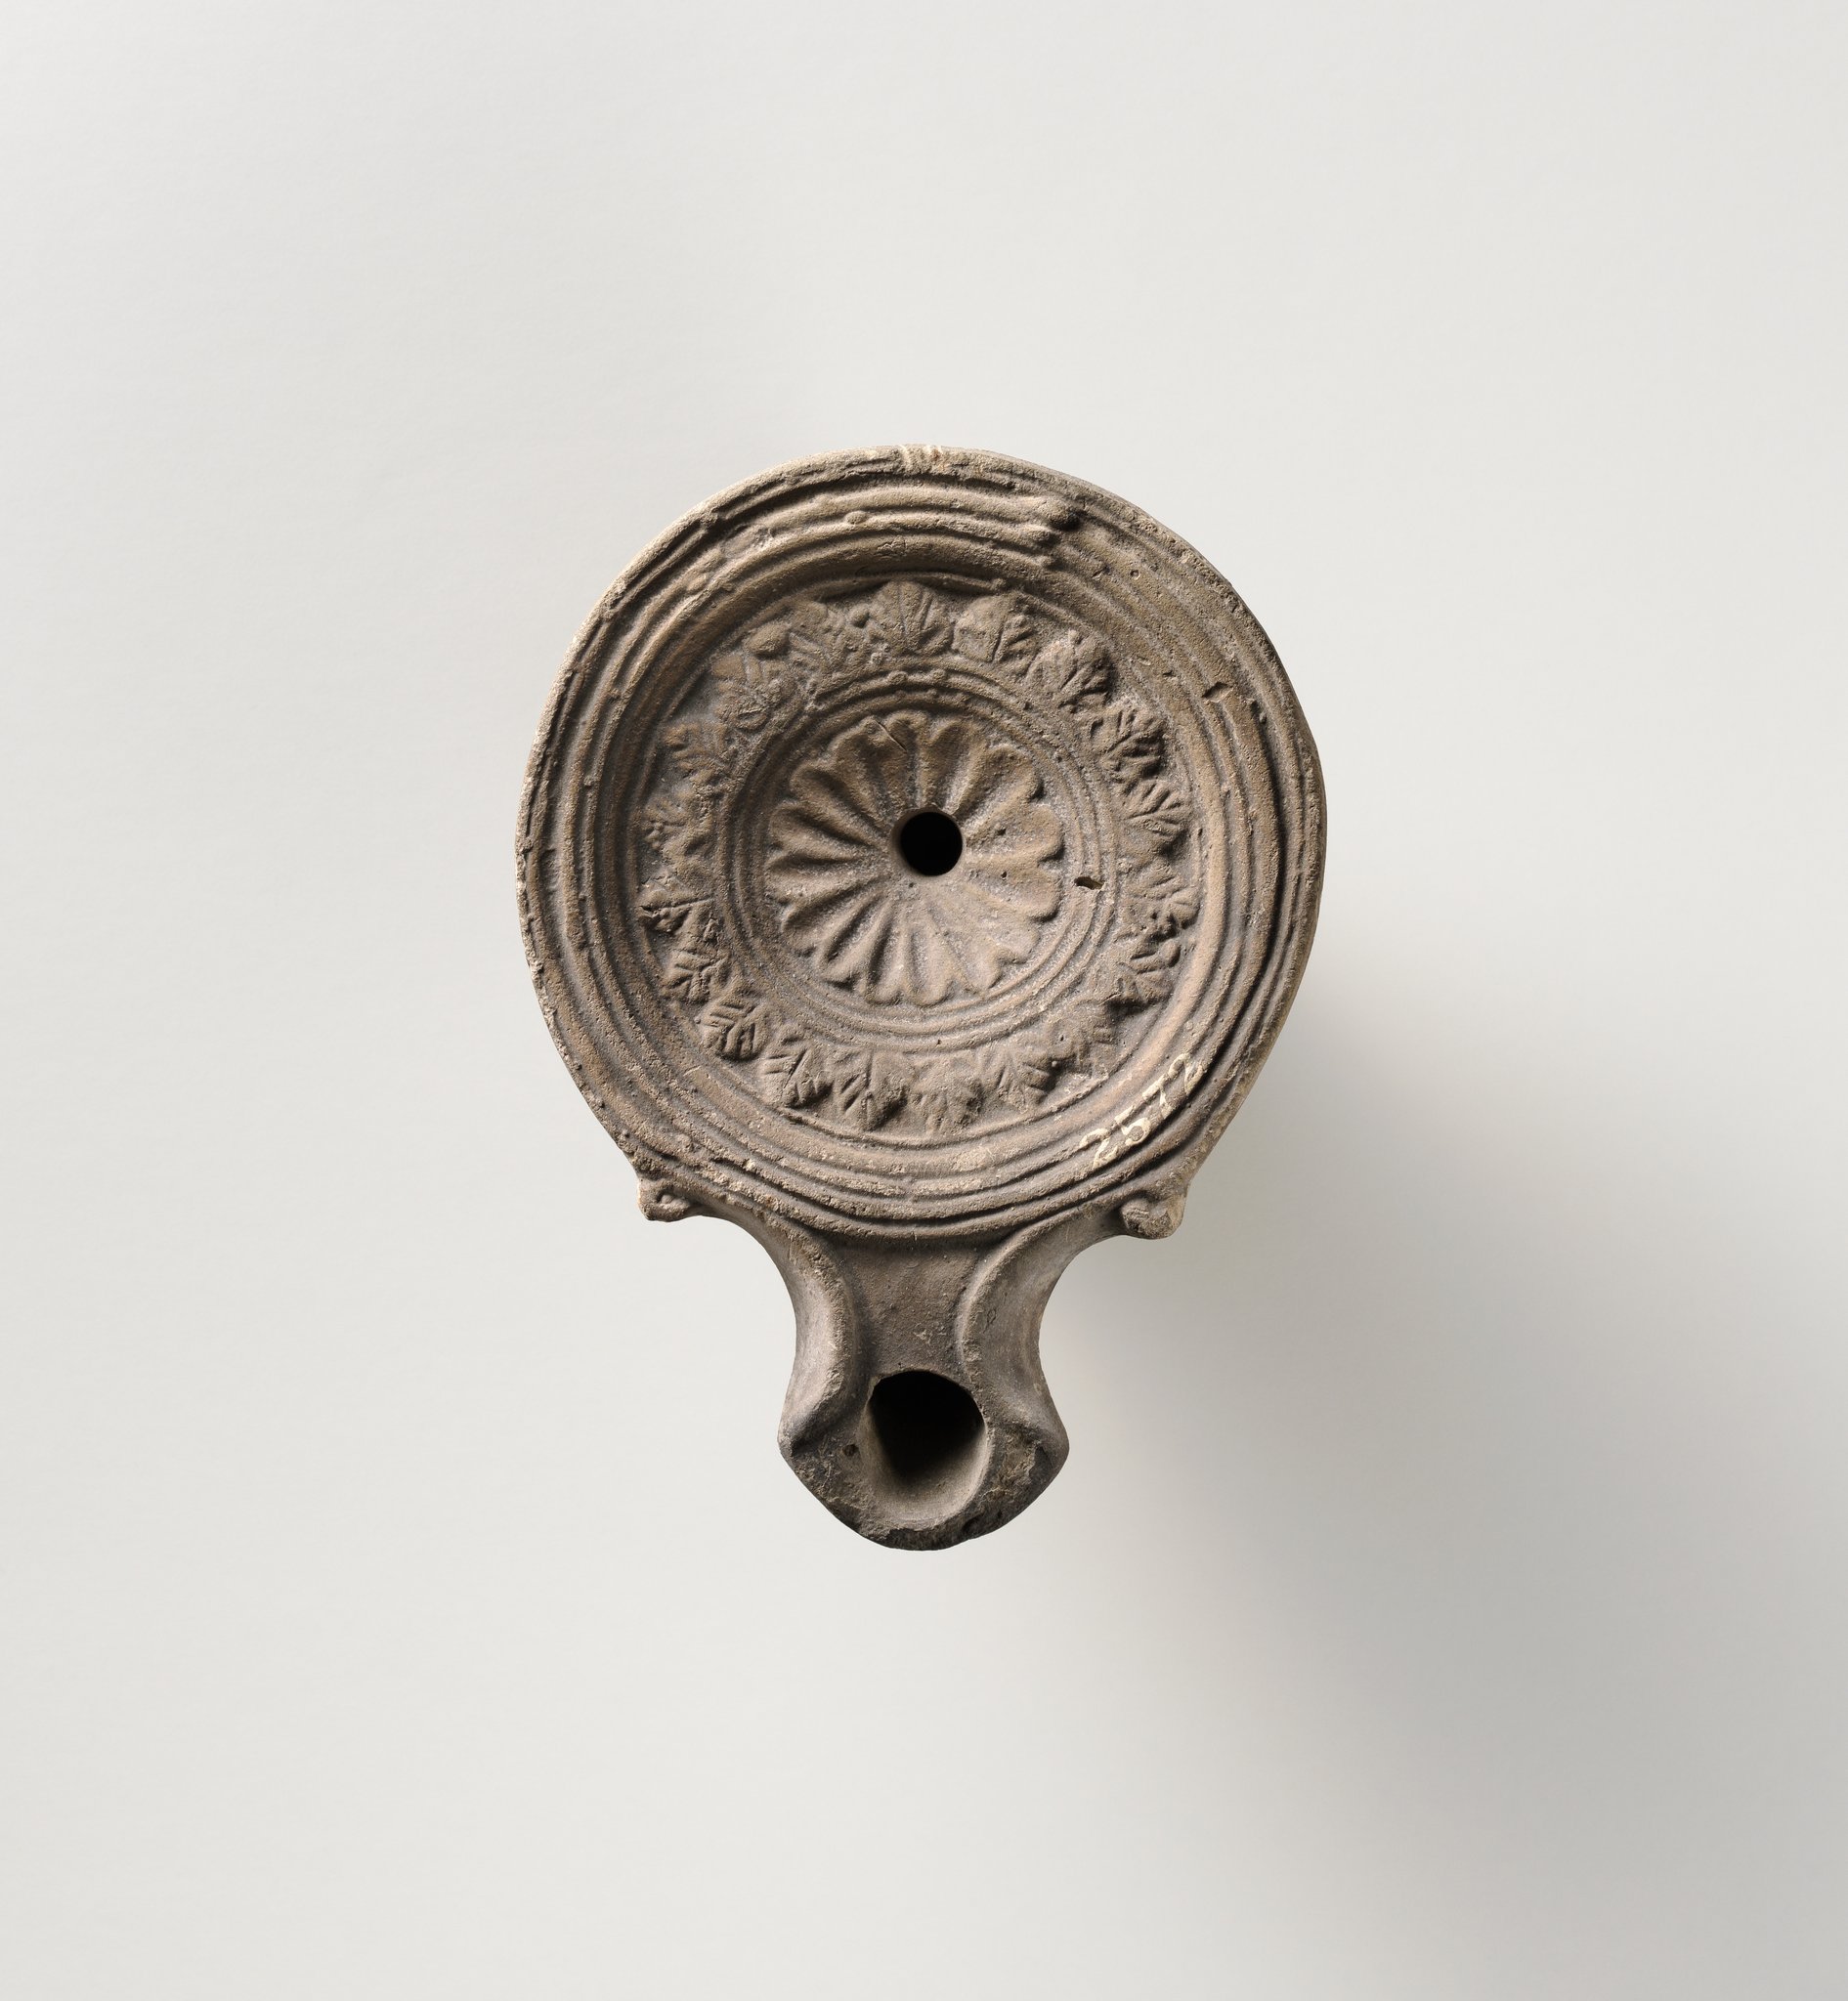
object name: lamp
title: Terracotta oil lamp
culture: roman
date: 100 BCE-100 CE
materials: terracotta